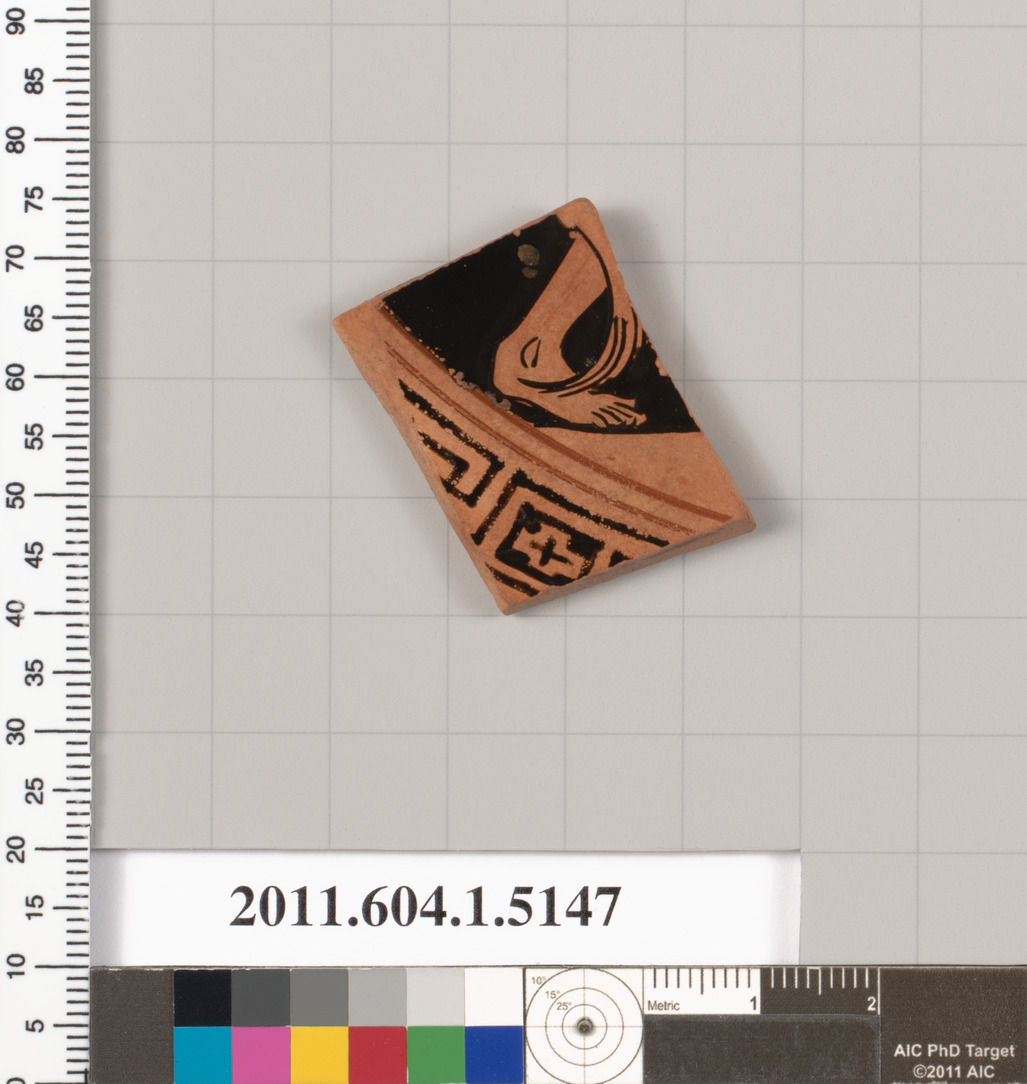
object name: kylix fragment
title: Terracotta fragment of a kylix (drinking cup)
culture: greek, attic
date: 490-480 BCE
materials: terracotta